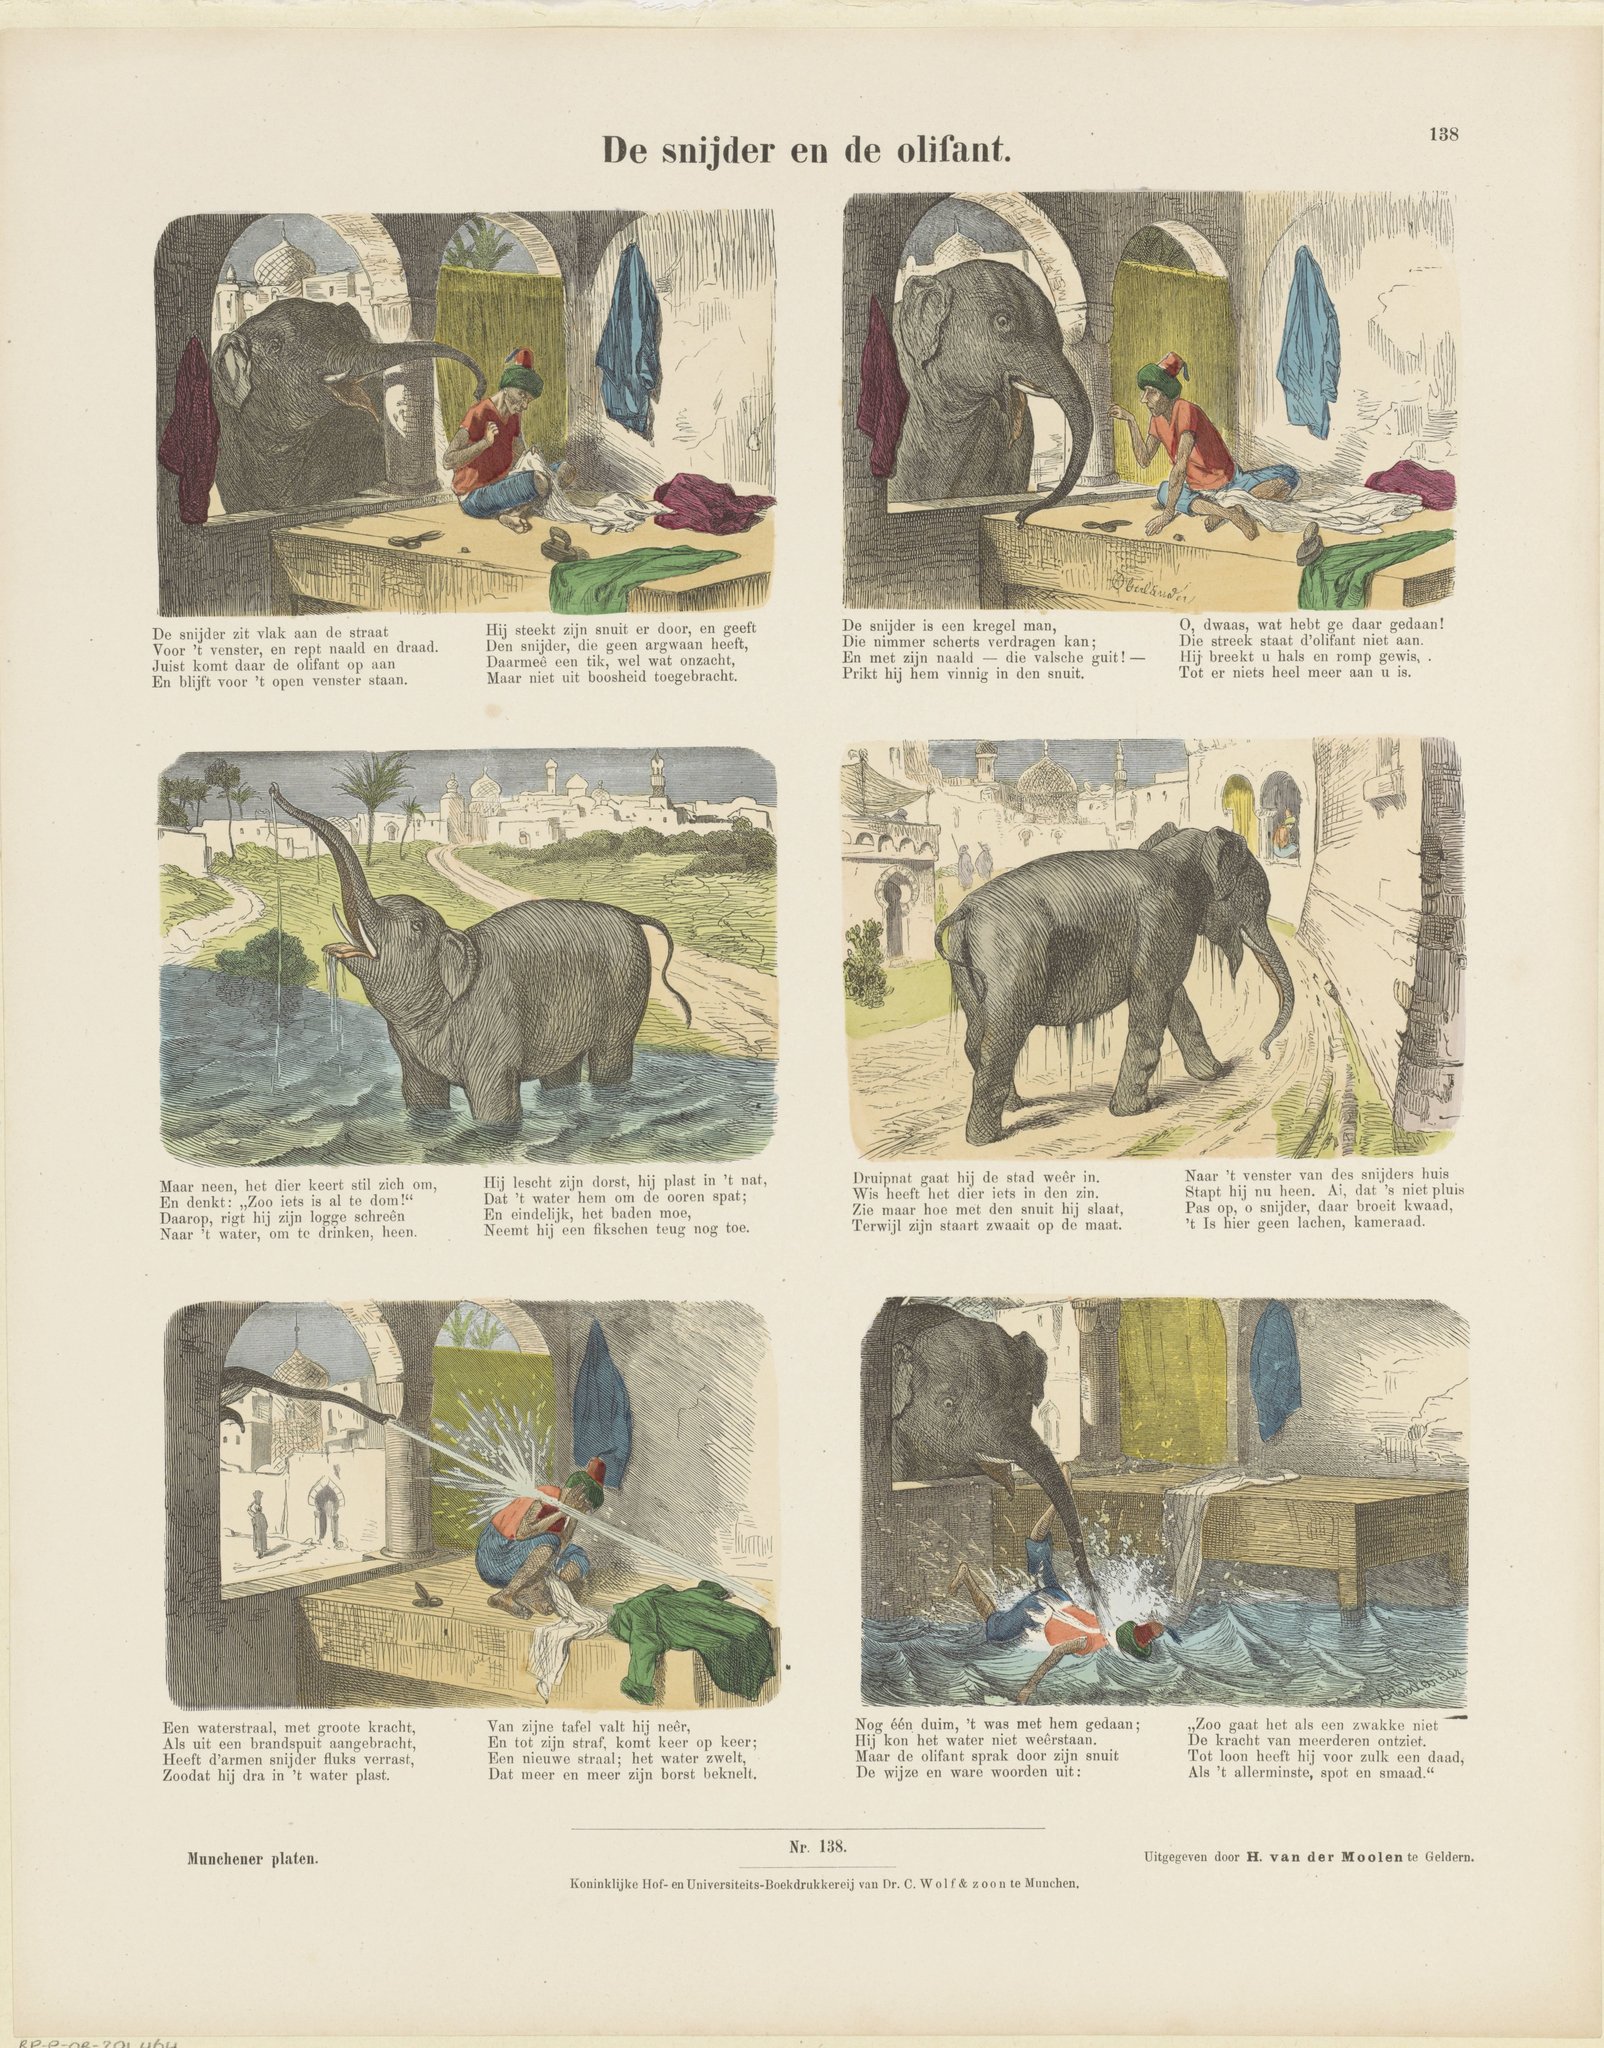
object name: print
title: Munchener platen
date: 1843-1920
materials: paper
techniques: colour, letterpress printing, engraving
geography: geldern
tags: tailor, dressmaker, trunked animals: elephant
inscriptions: collector's mark: Lugt 2760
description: Blad met 6 voorstellingen over een olifant die wraak neemt op een kleermaker die in zijn snuit prikte met een naald. Onder elke voorstelling een achtregelig vers in twee kolommen. Genummerd midden onder: Nro. 138. Genummerd rechtsboven: 138.